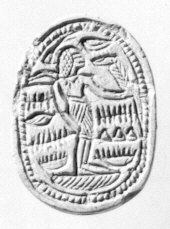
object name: stamp seal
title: Scarab seal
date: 1700-1560 BCE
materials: stone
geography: levant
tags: scarabs